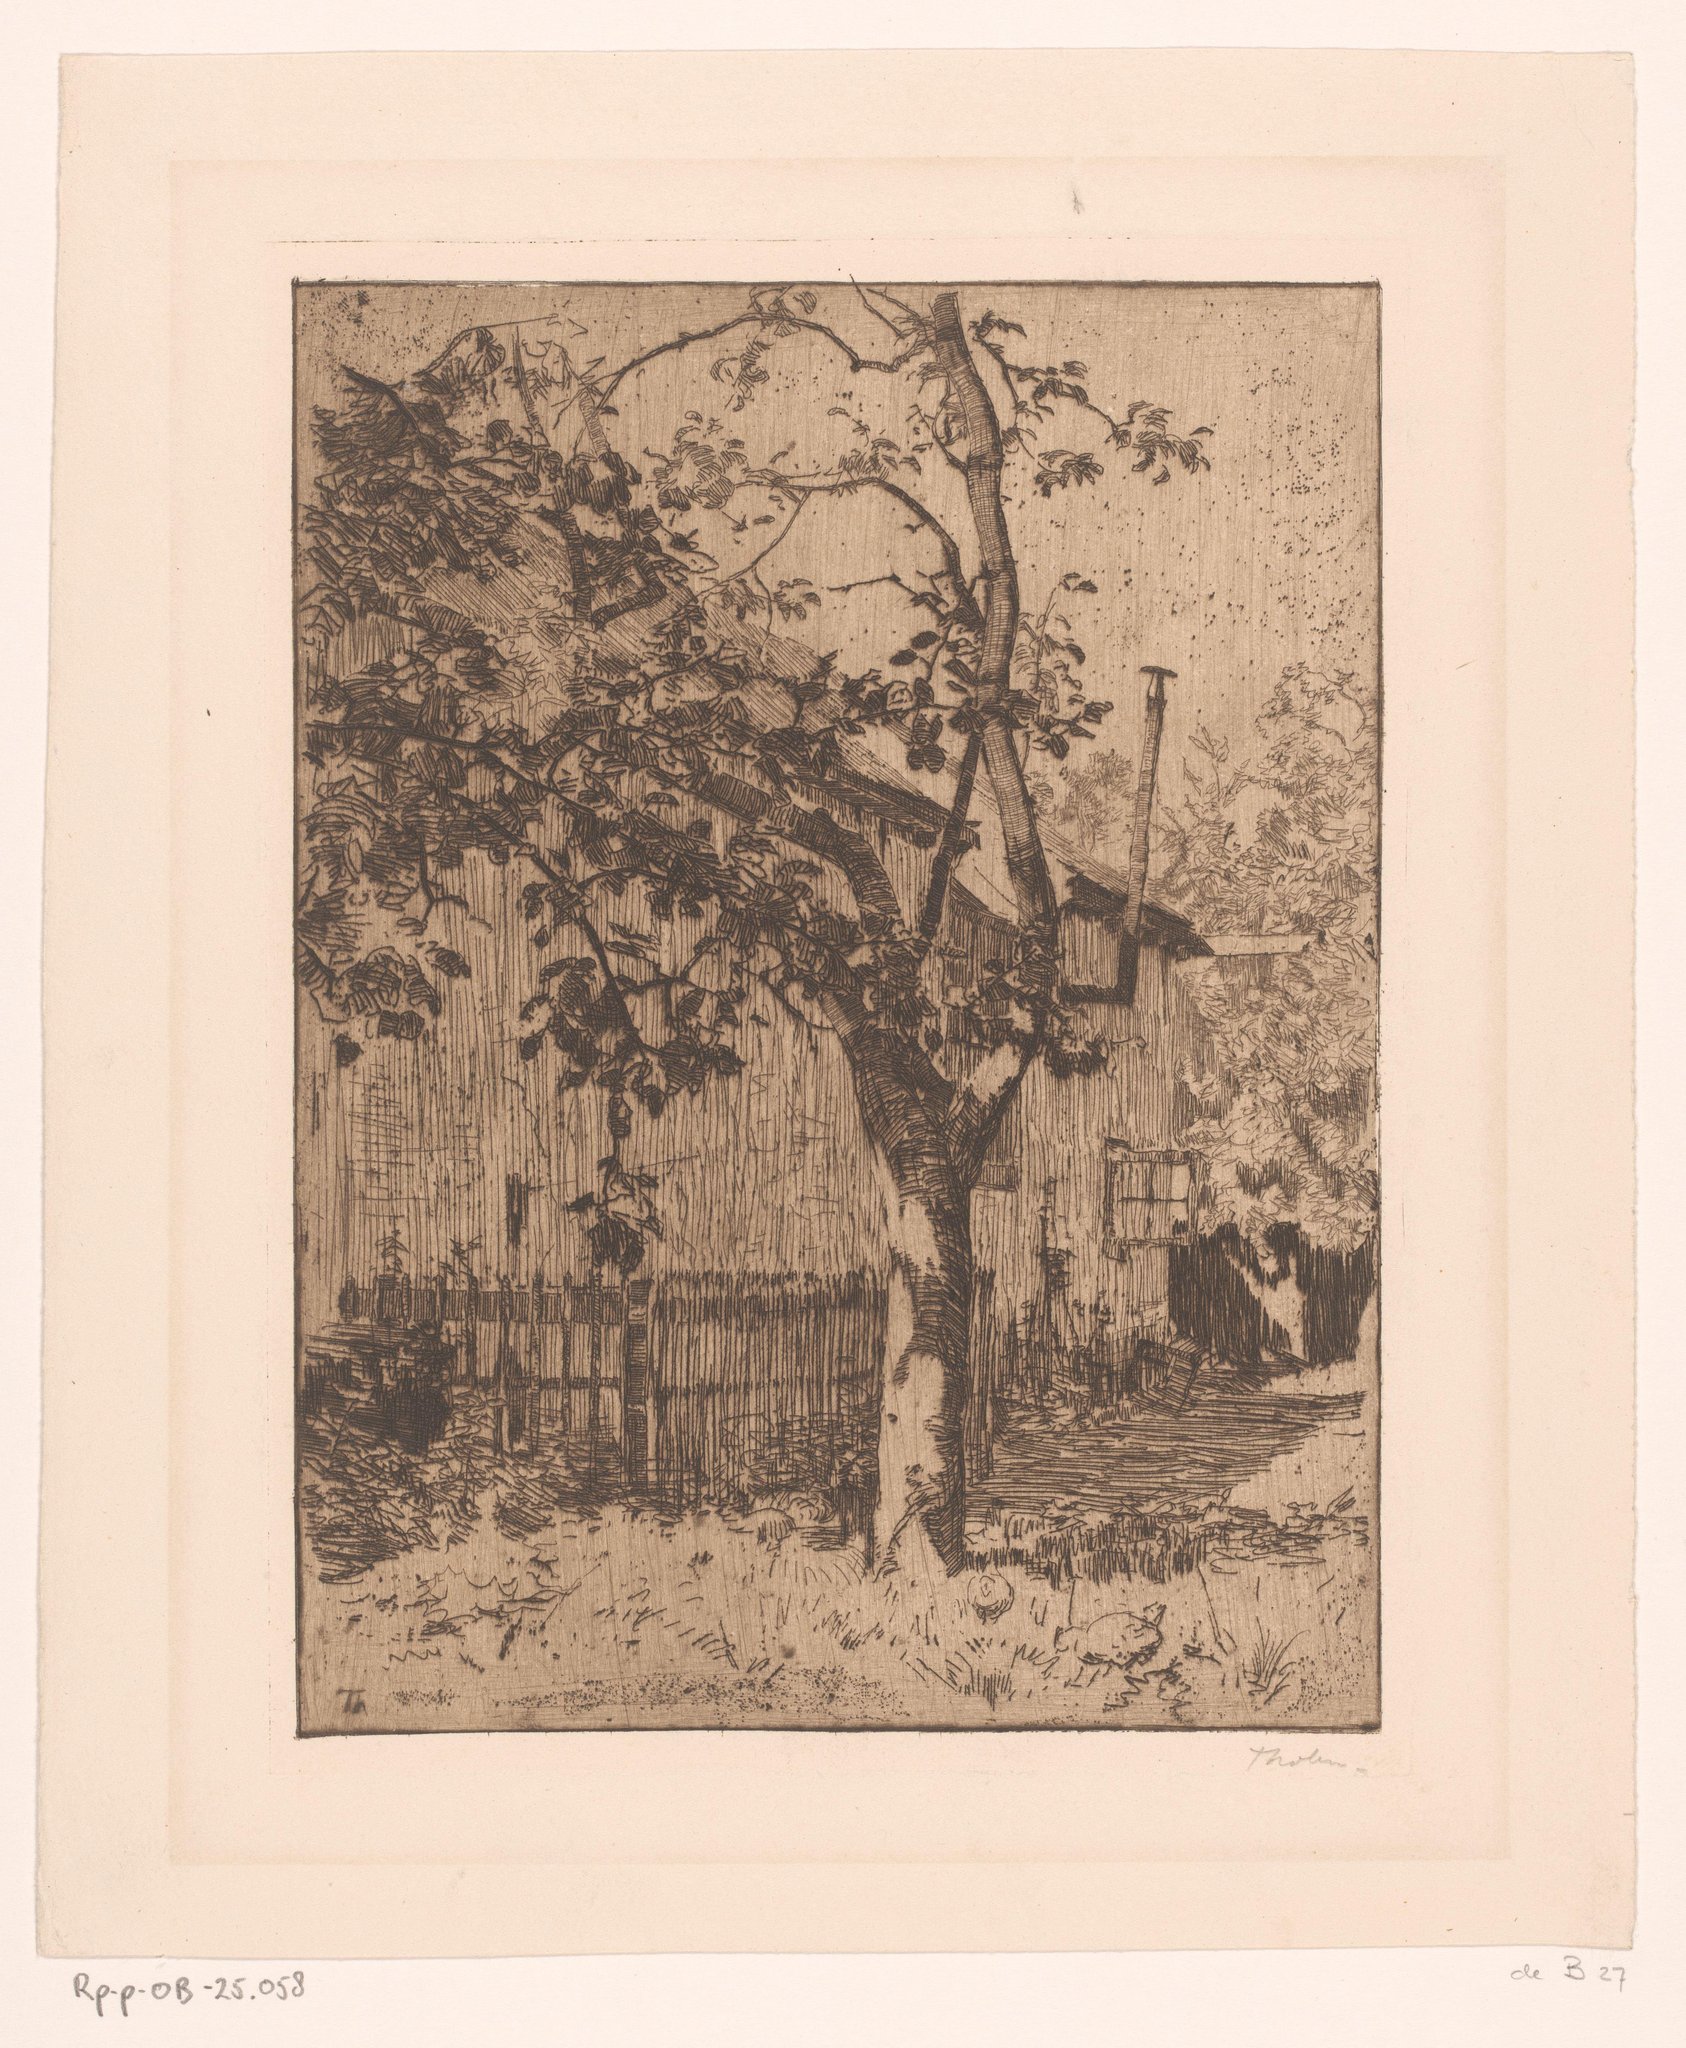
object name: print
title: Atelier, Ewijkshoeve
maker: willem bastiaan tholen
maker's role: draughtsman, painter, print maker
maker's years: 1860-1931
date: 1870-1914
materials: paper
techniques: drypoint, intaglio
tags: rural housing, e.g. country-house, villa, cottage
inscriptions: collector's mark: Lugt 2228